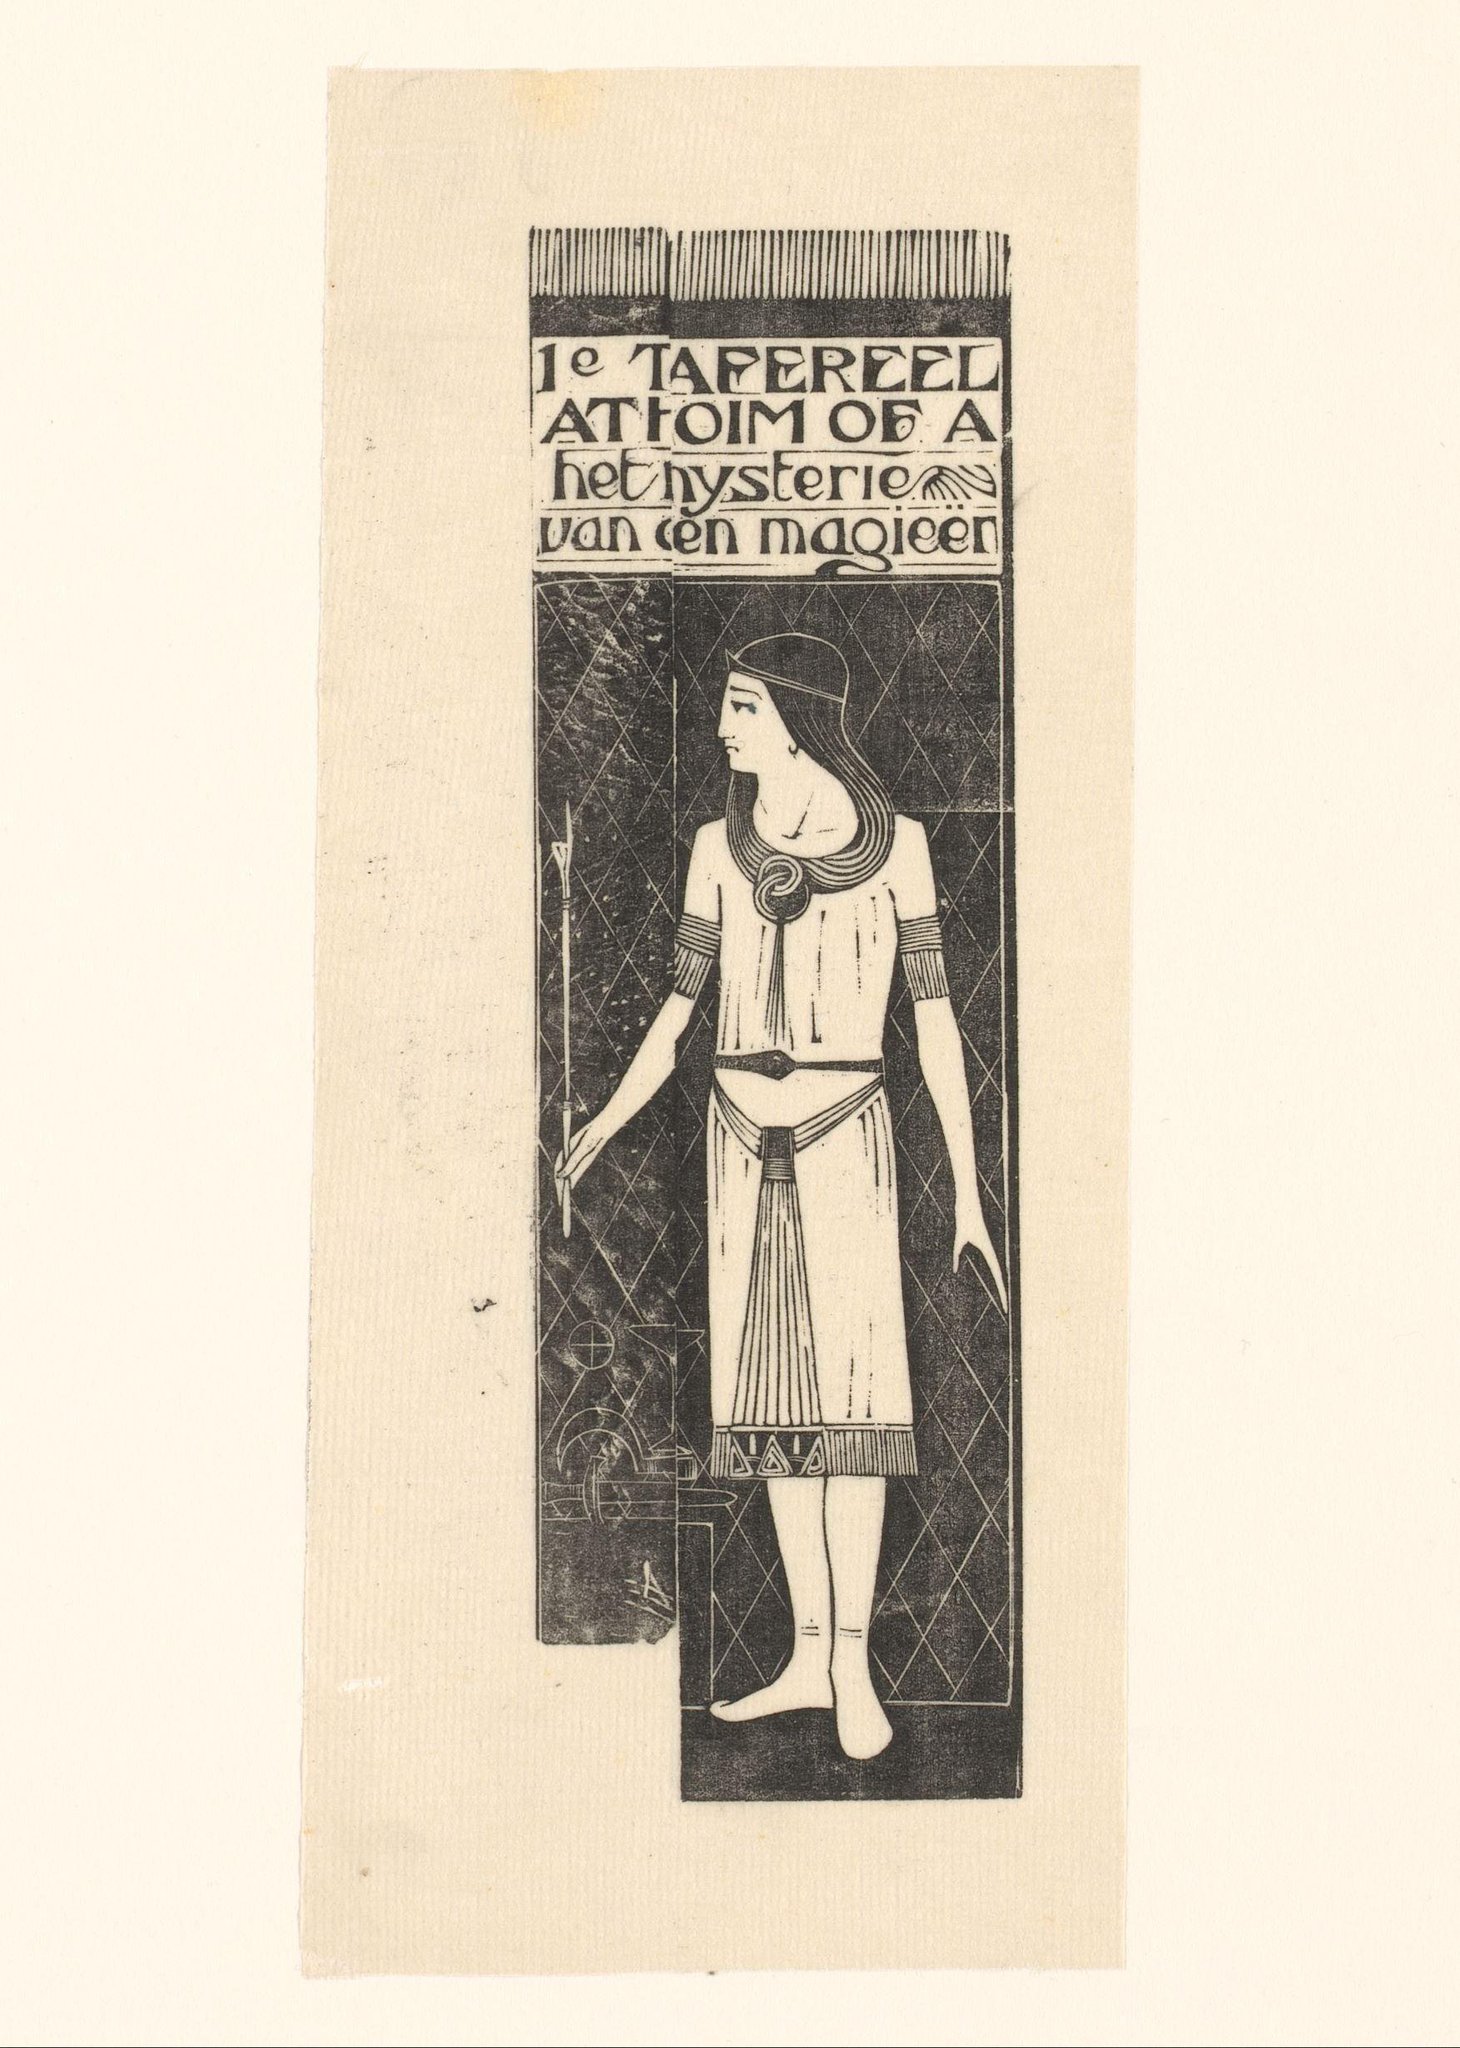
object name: print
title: Athiom of A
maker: karel petrus cornelis de bazel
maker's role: draughtsman, print maker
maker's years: 1869-1923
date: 1895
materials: paper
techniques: woodcut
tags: standing figure, sorcerer, magician, wizard, warlock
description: Deze prent is gebruikt voor: Licht en waarheid. Orgaan van de Vereeniging 'Wie denkt overwint', 5 oktober 1895. Waarschijnlijk is het blok gespleten geweest en later weer aan elkaar gezet. Als gevolg daarvan ontbreekt een verticale strook middenin de prent. Ook ontbreekt een vierkant stuk linksonder. Zie Braches, 2016 voor details.